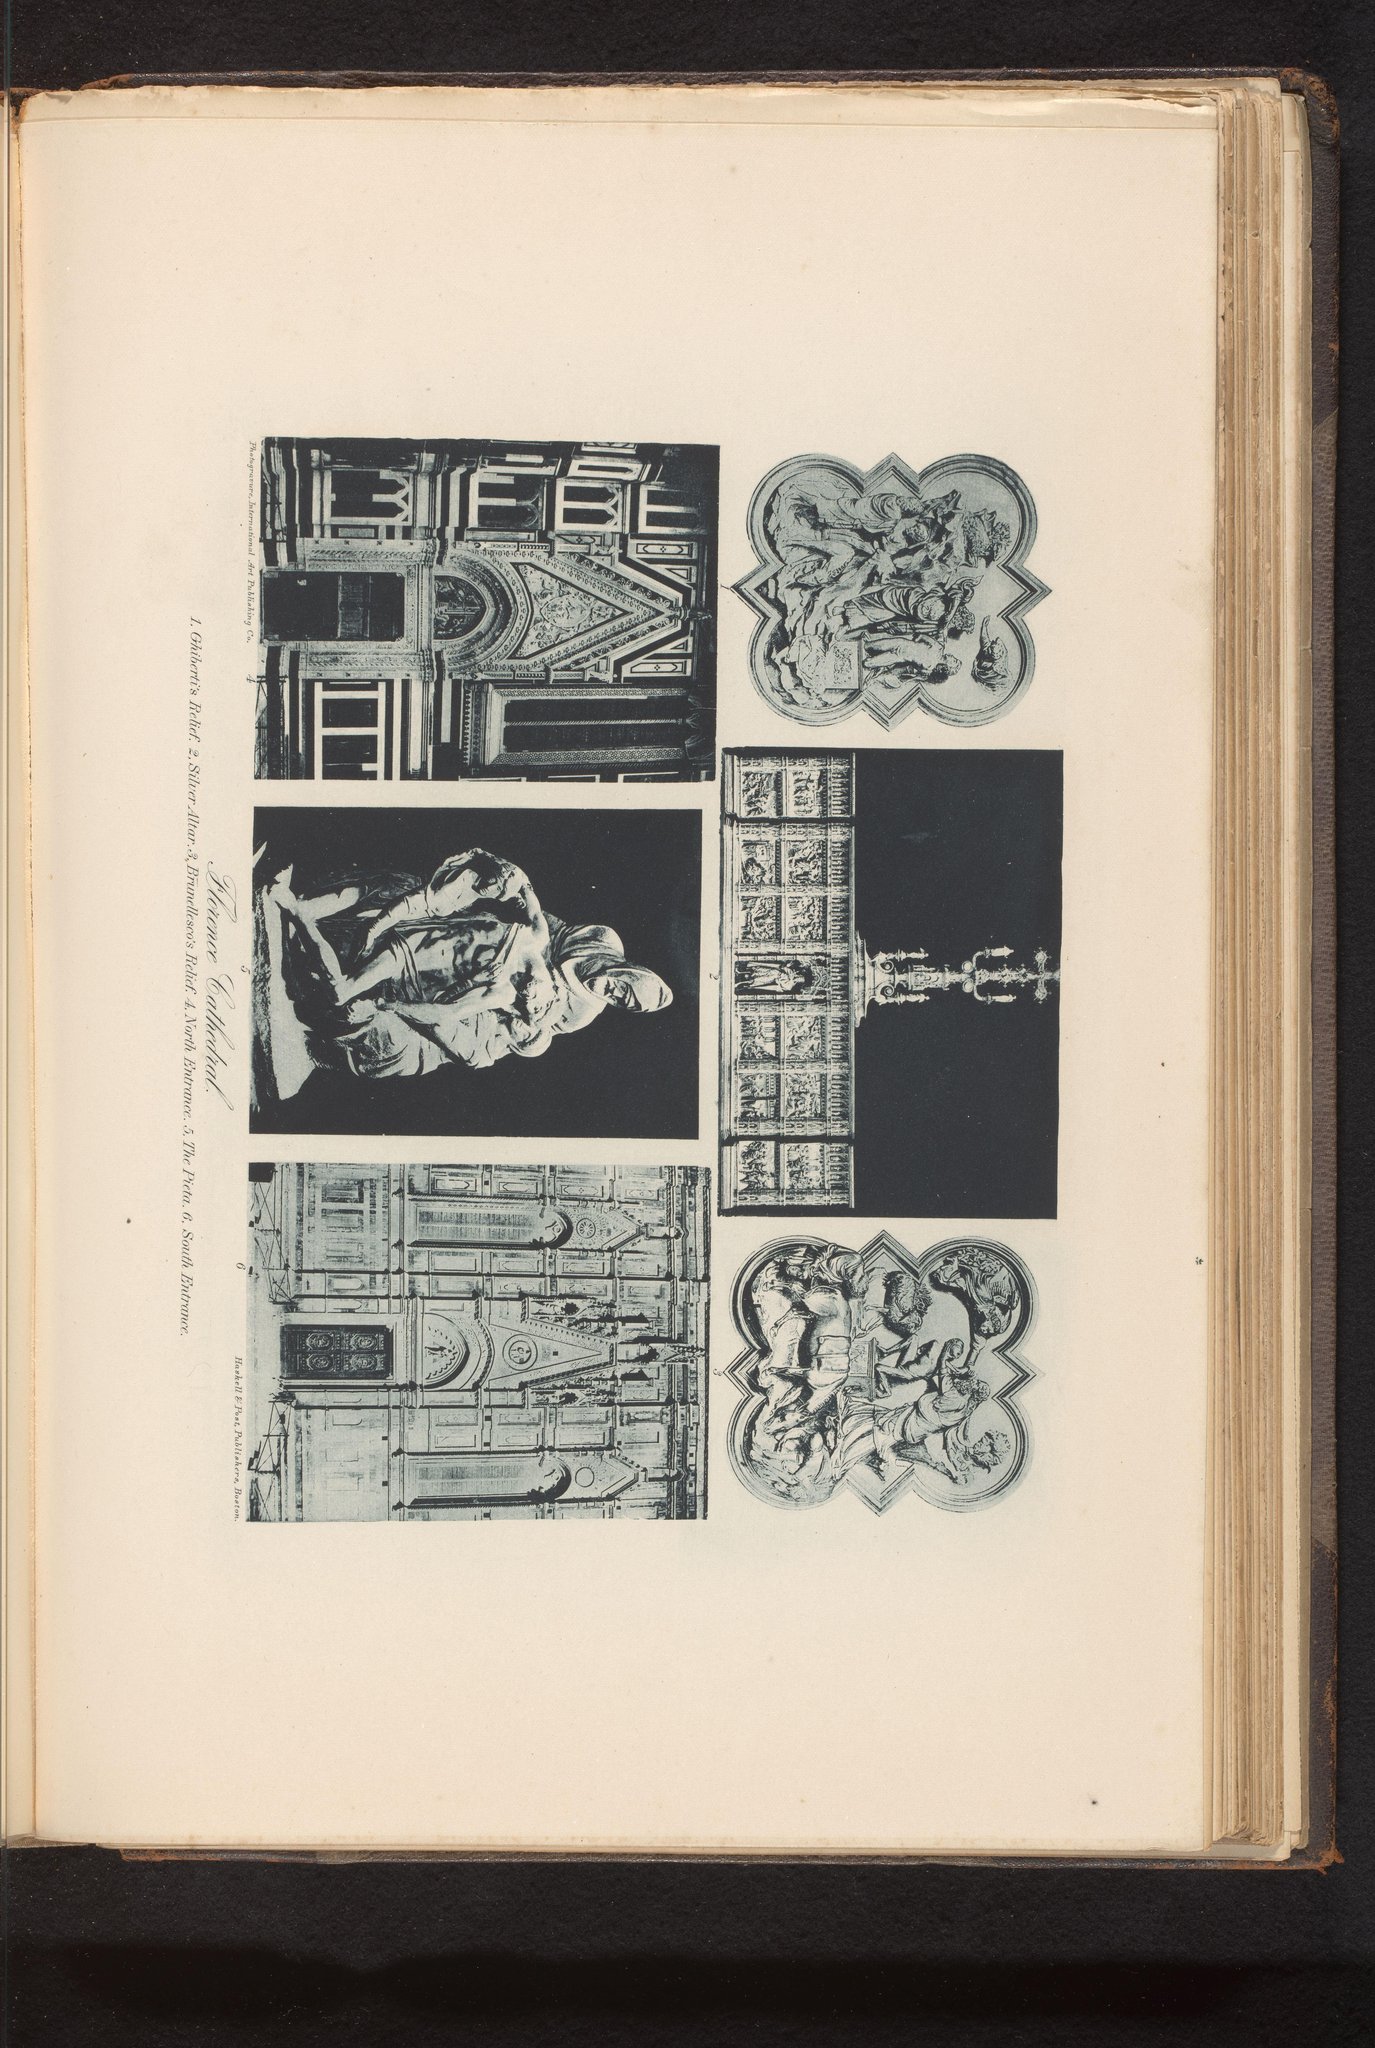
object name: page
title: Florence Cathedral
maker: Anonymous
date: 1881-1886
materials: paper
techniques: photograph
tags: parts of church exterior and annexes: portal, 'pietas'; 'pietà' (ripa), sculpture (+ relief ~ sculpture)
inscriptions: inscription: ‘1. Ghiberti's Rlief. 2, Silver Altar. 3, Brunellesco's Relief. 4, North Entrance. 5, The Pieta. 6, South Entrance.’